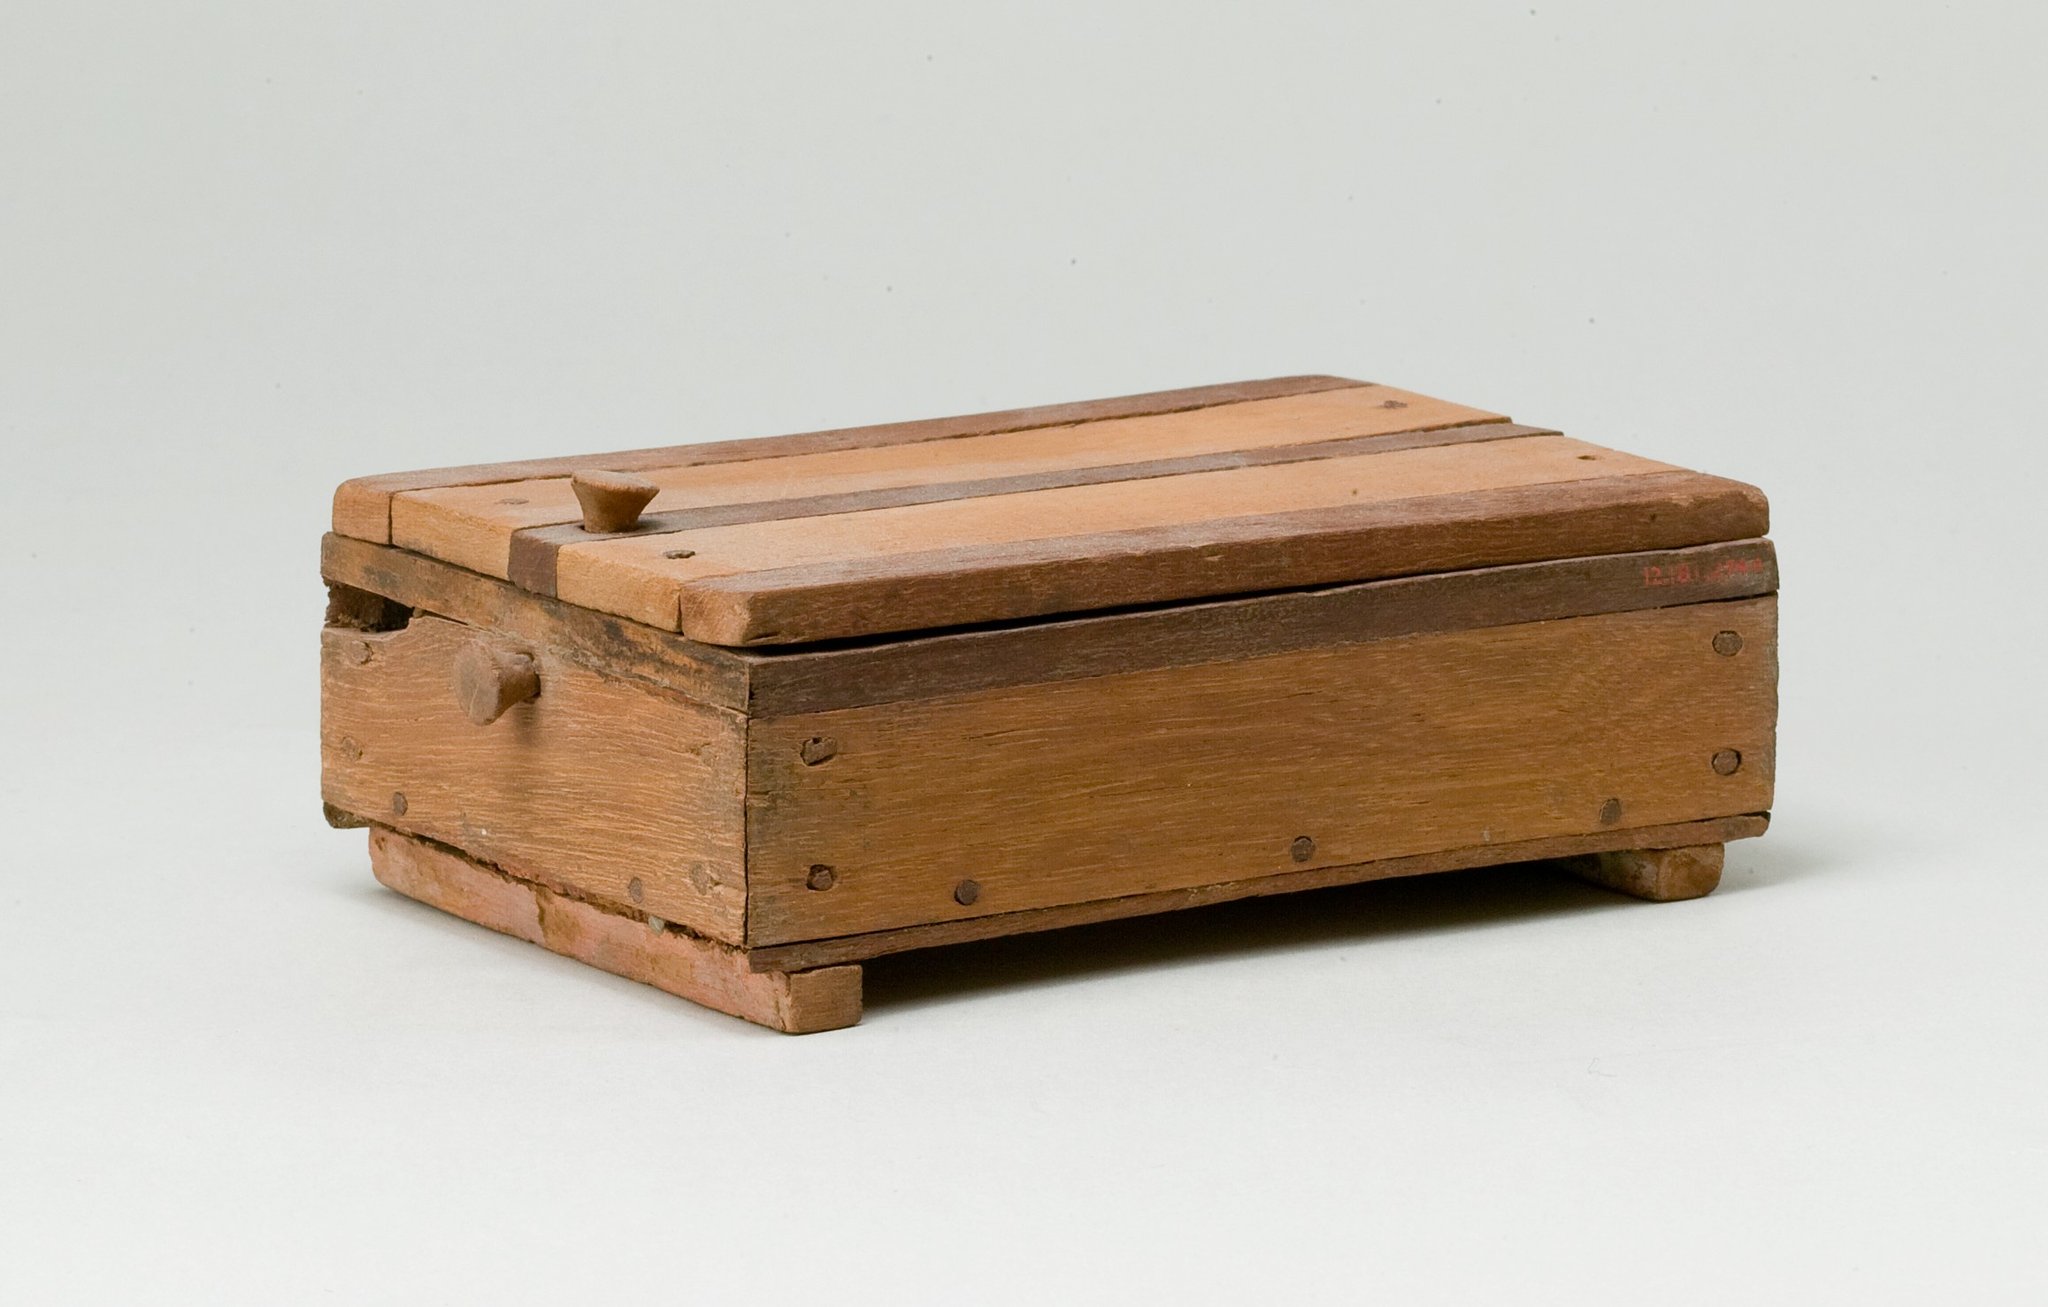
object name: box with lid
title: Box, lid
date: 1991-1450 BCE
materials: wood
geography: egypt